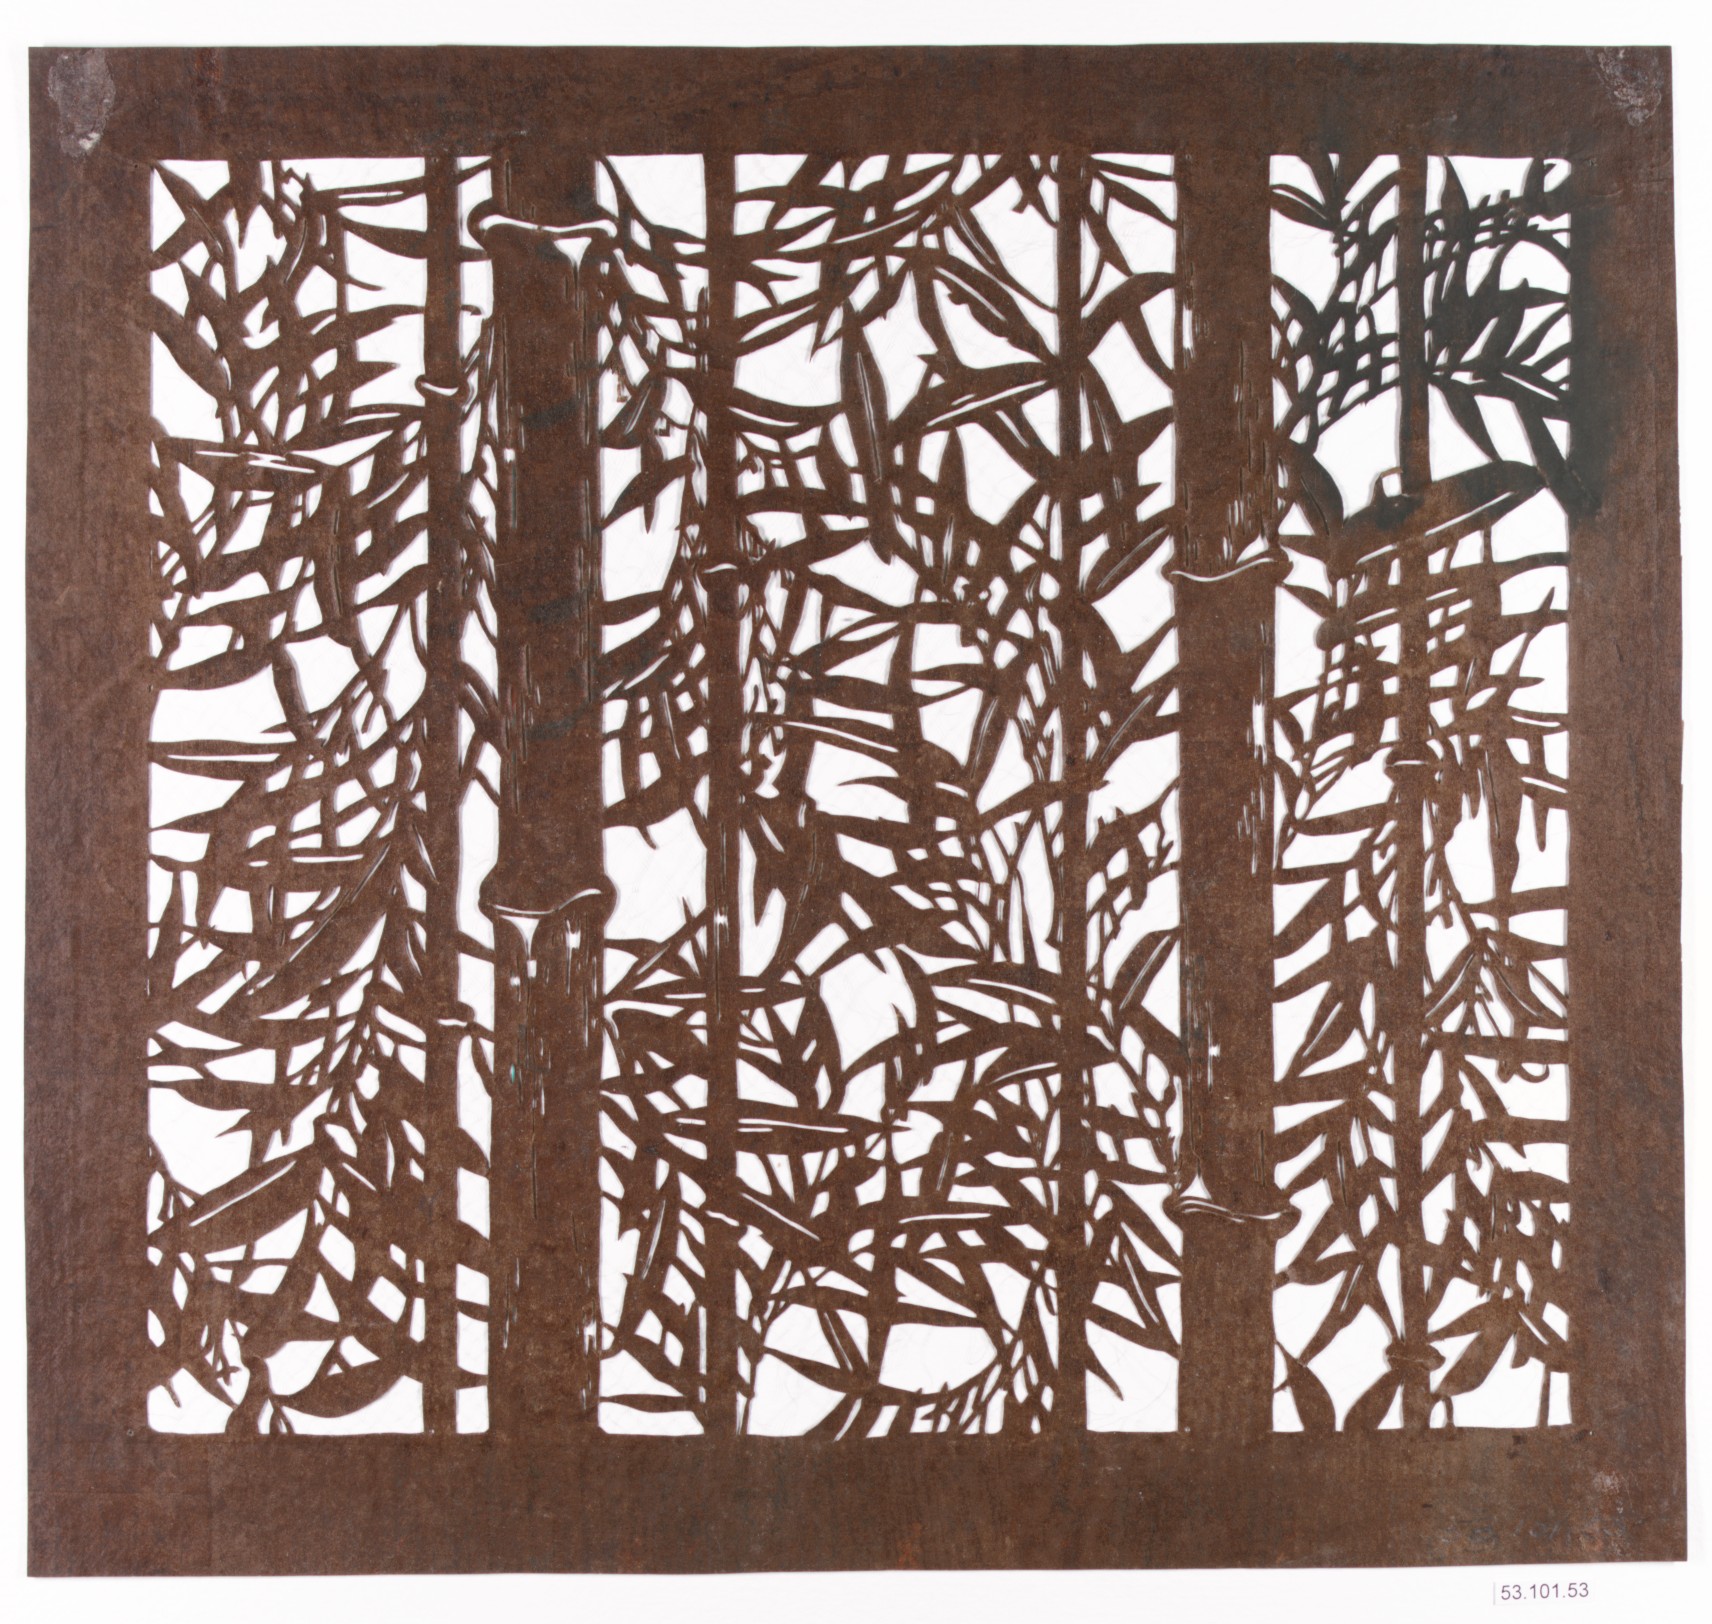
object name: stencil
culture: japanese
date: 1615-1868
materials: paper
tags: bamboo